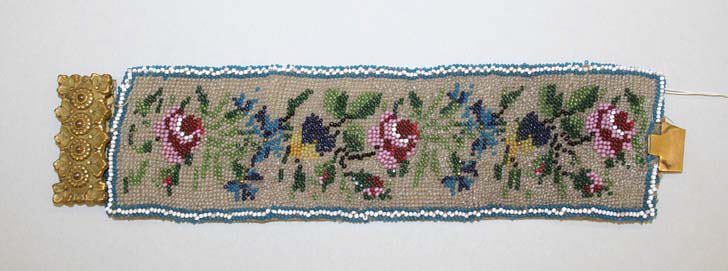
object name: bracelet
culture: american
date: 1834-1866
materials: metal, silk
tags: flowers